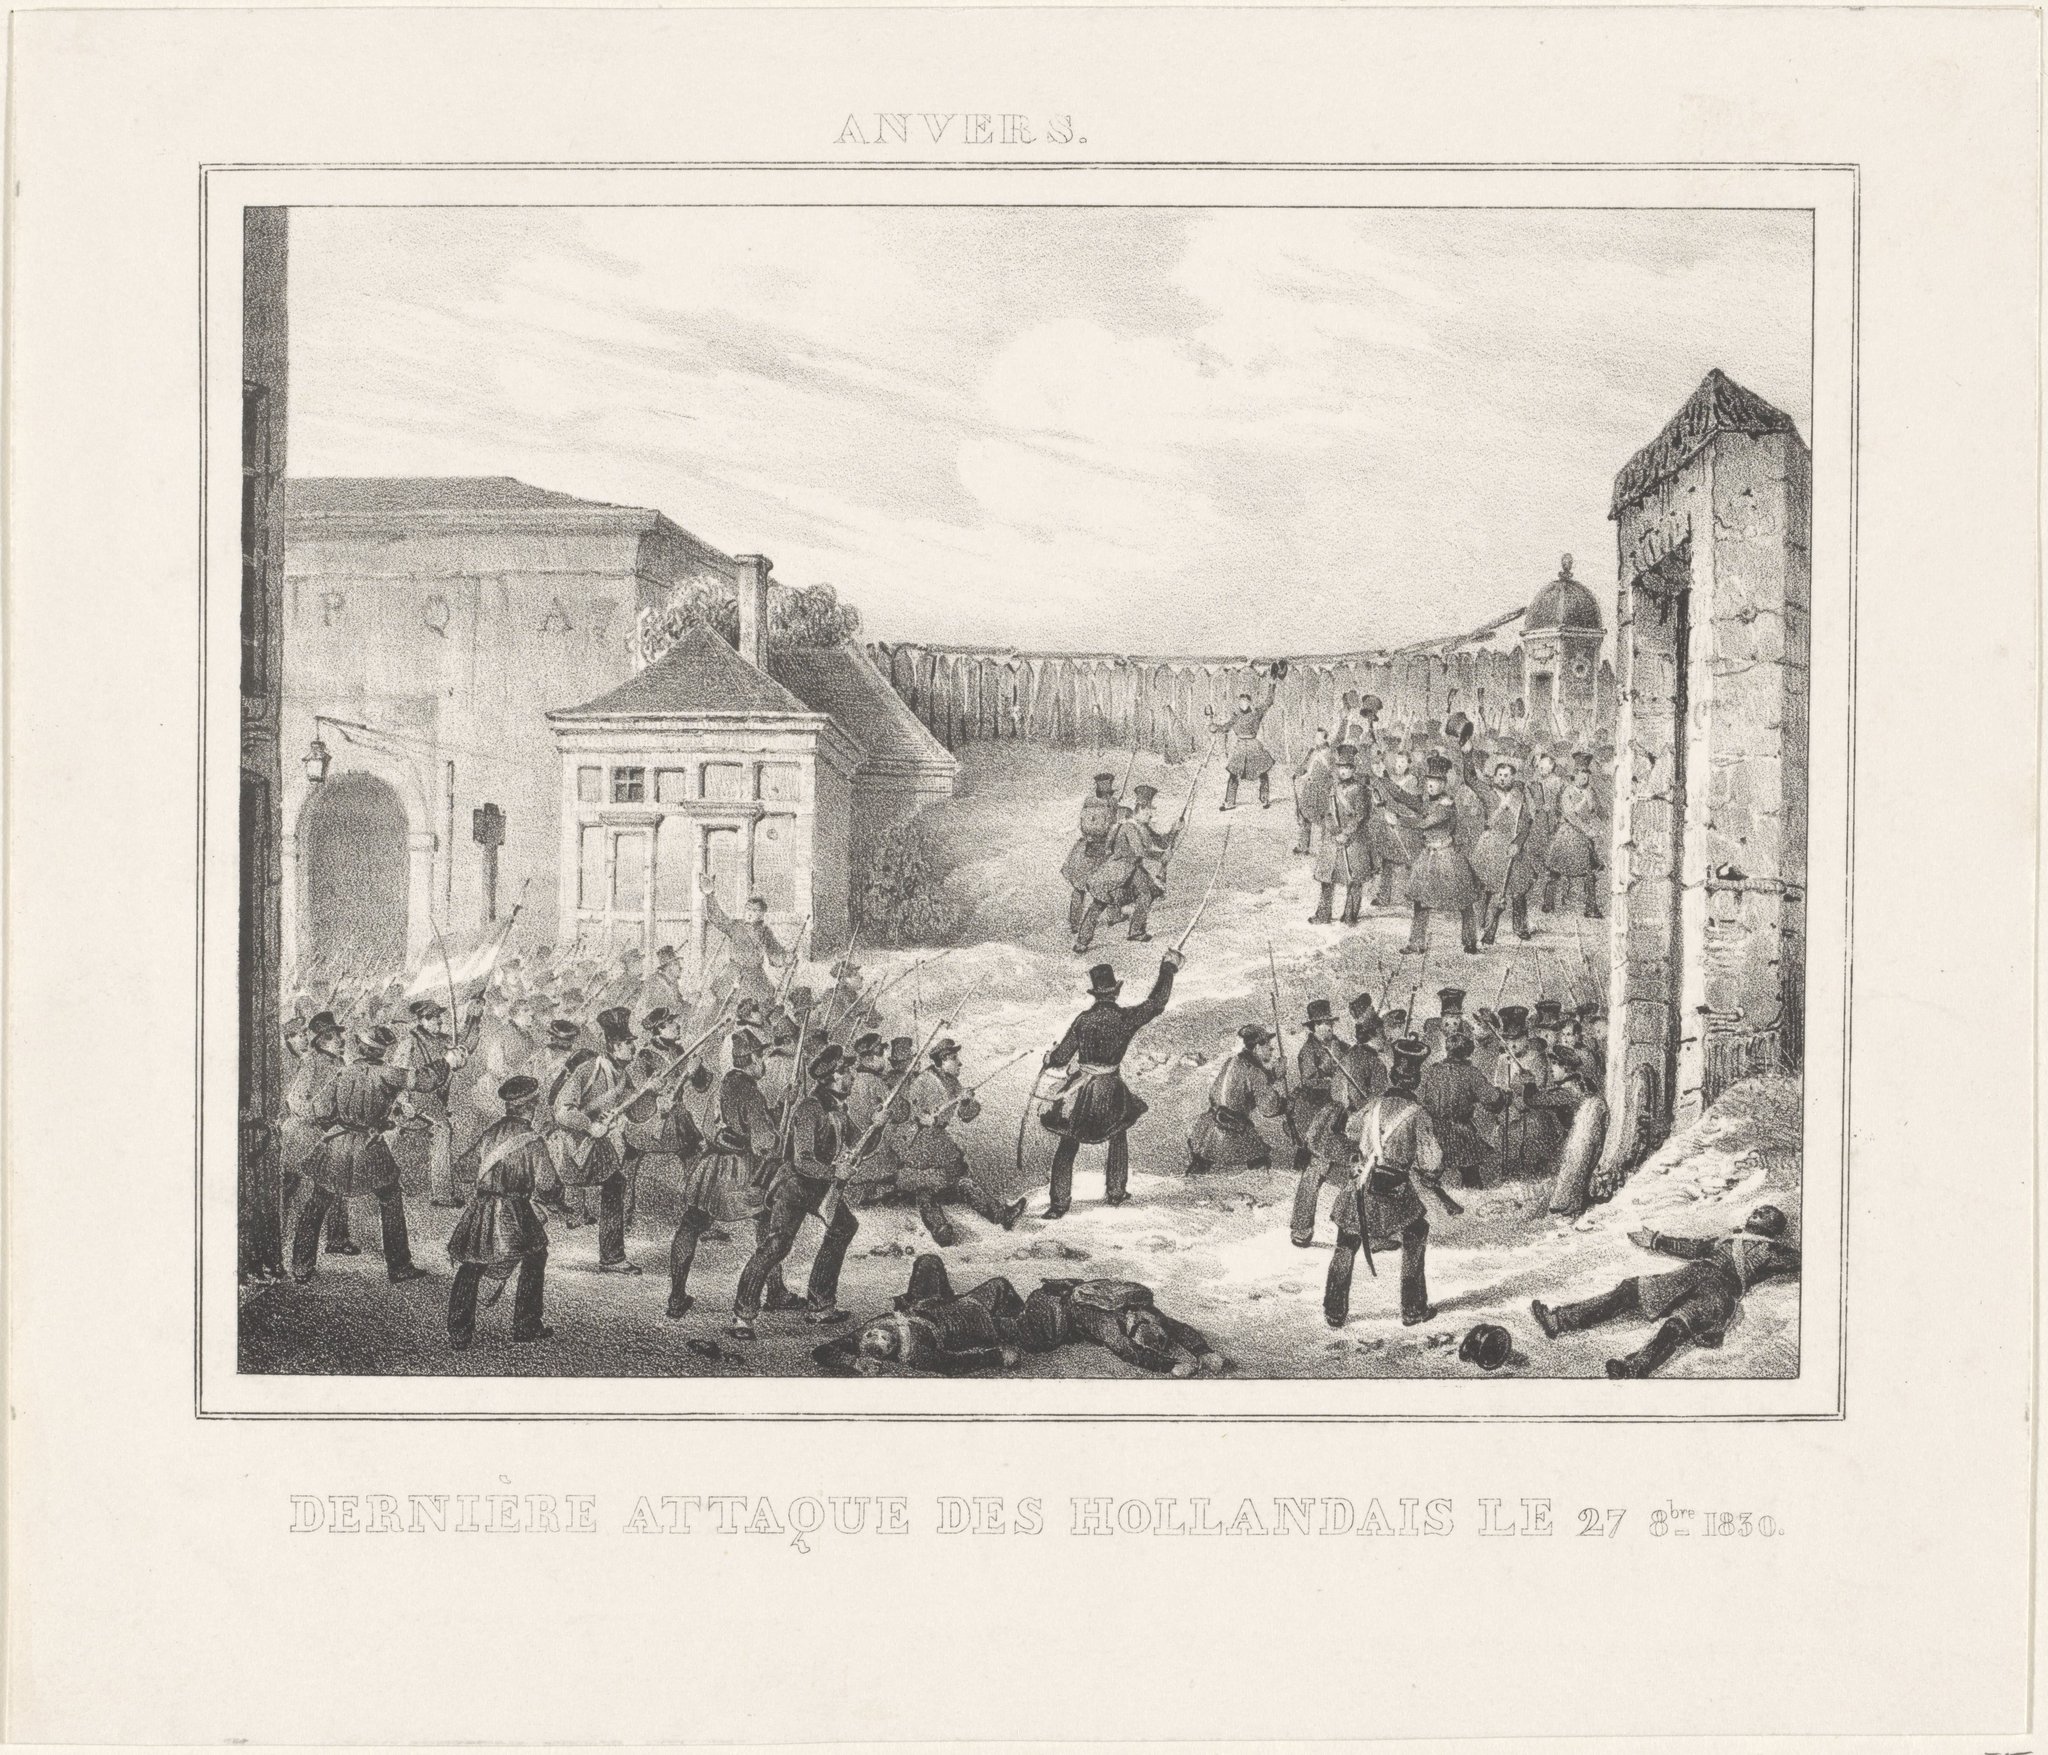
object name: print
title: Laatste aanval op de Nederlandse troepen in Antwerpen, 1830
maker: Anonymous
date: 1830-1831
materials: paper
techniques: lithograph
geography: brussels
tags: street-fights, riots, antwerp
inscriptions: collector's mark: Lugt 2228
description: Laatste aanval door Belgische opstandelingen op de Nederlandse troepen in Antwerpen, 27 oktober 1830. Rechts een stadspoort. Onderdeel van een groep van prenten uit verschillende andere series verwant aan de platen in het recueil over de gebeurtenissen tijdens de Belgische Revolutie in Brussel, Antwerpen en andere steden in de periode 25 augustus 1830 tot 27 maart 1831.